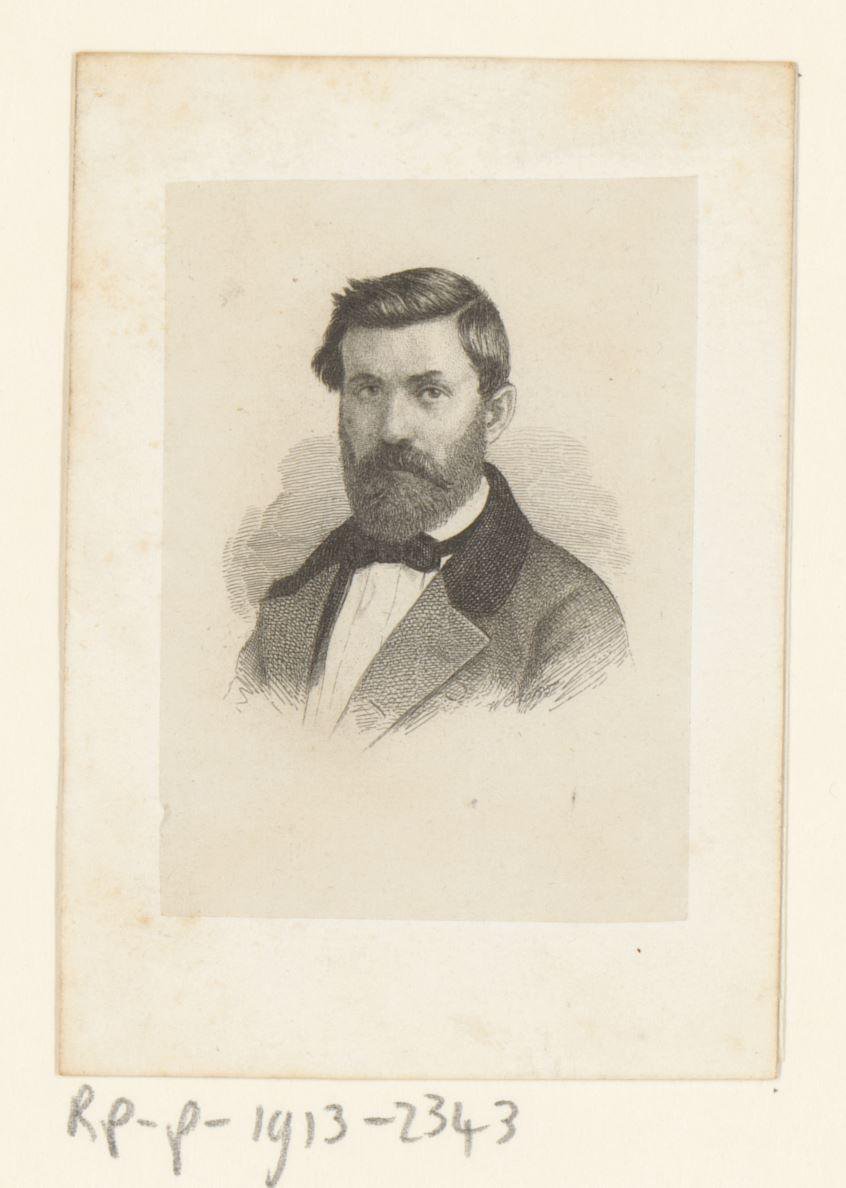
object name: print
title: Zelfportret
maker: georg otto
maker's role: print maker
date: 1800-1899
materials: paper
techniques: etching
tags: georg otto, historical persons, portrait, self-portrait of artist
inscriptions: collector's mark: Lugt 1485, collector's mark: Lugt 2228